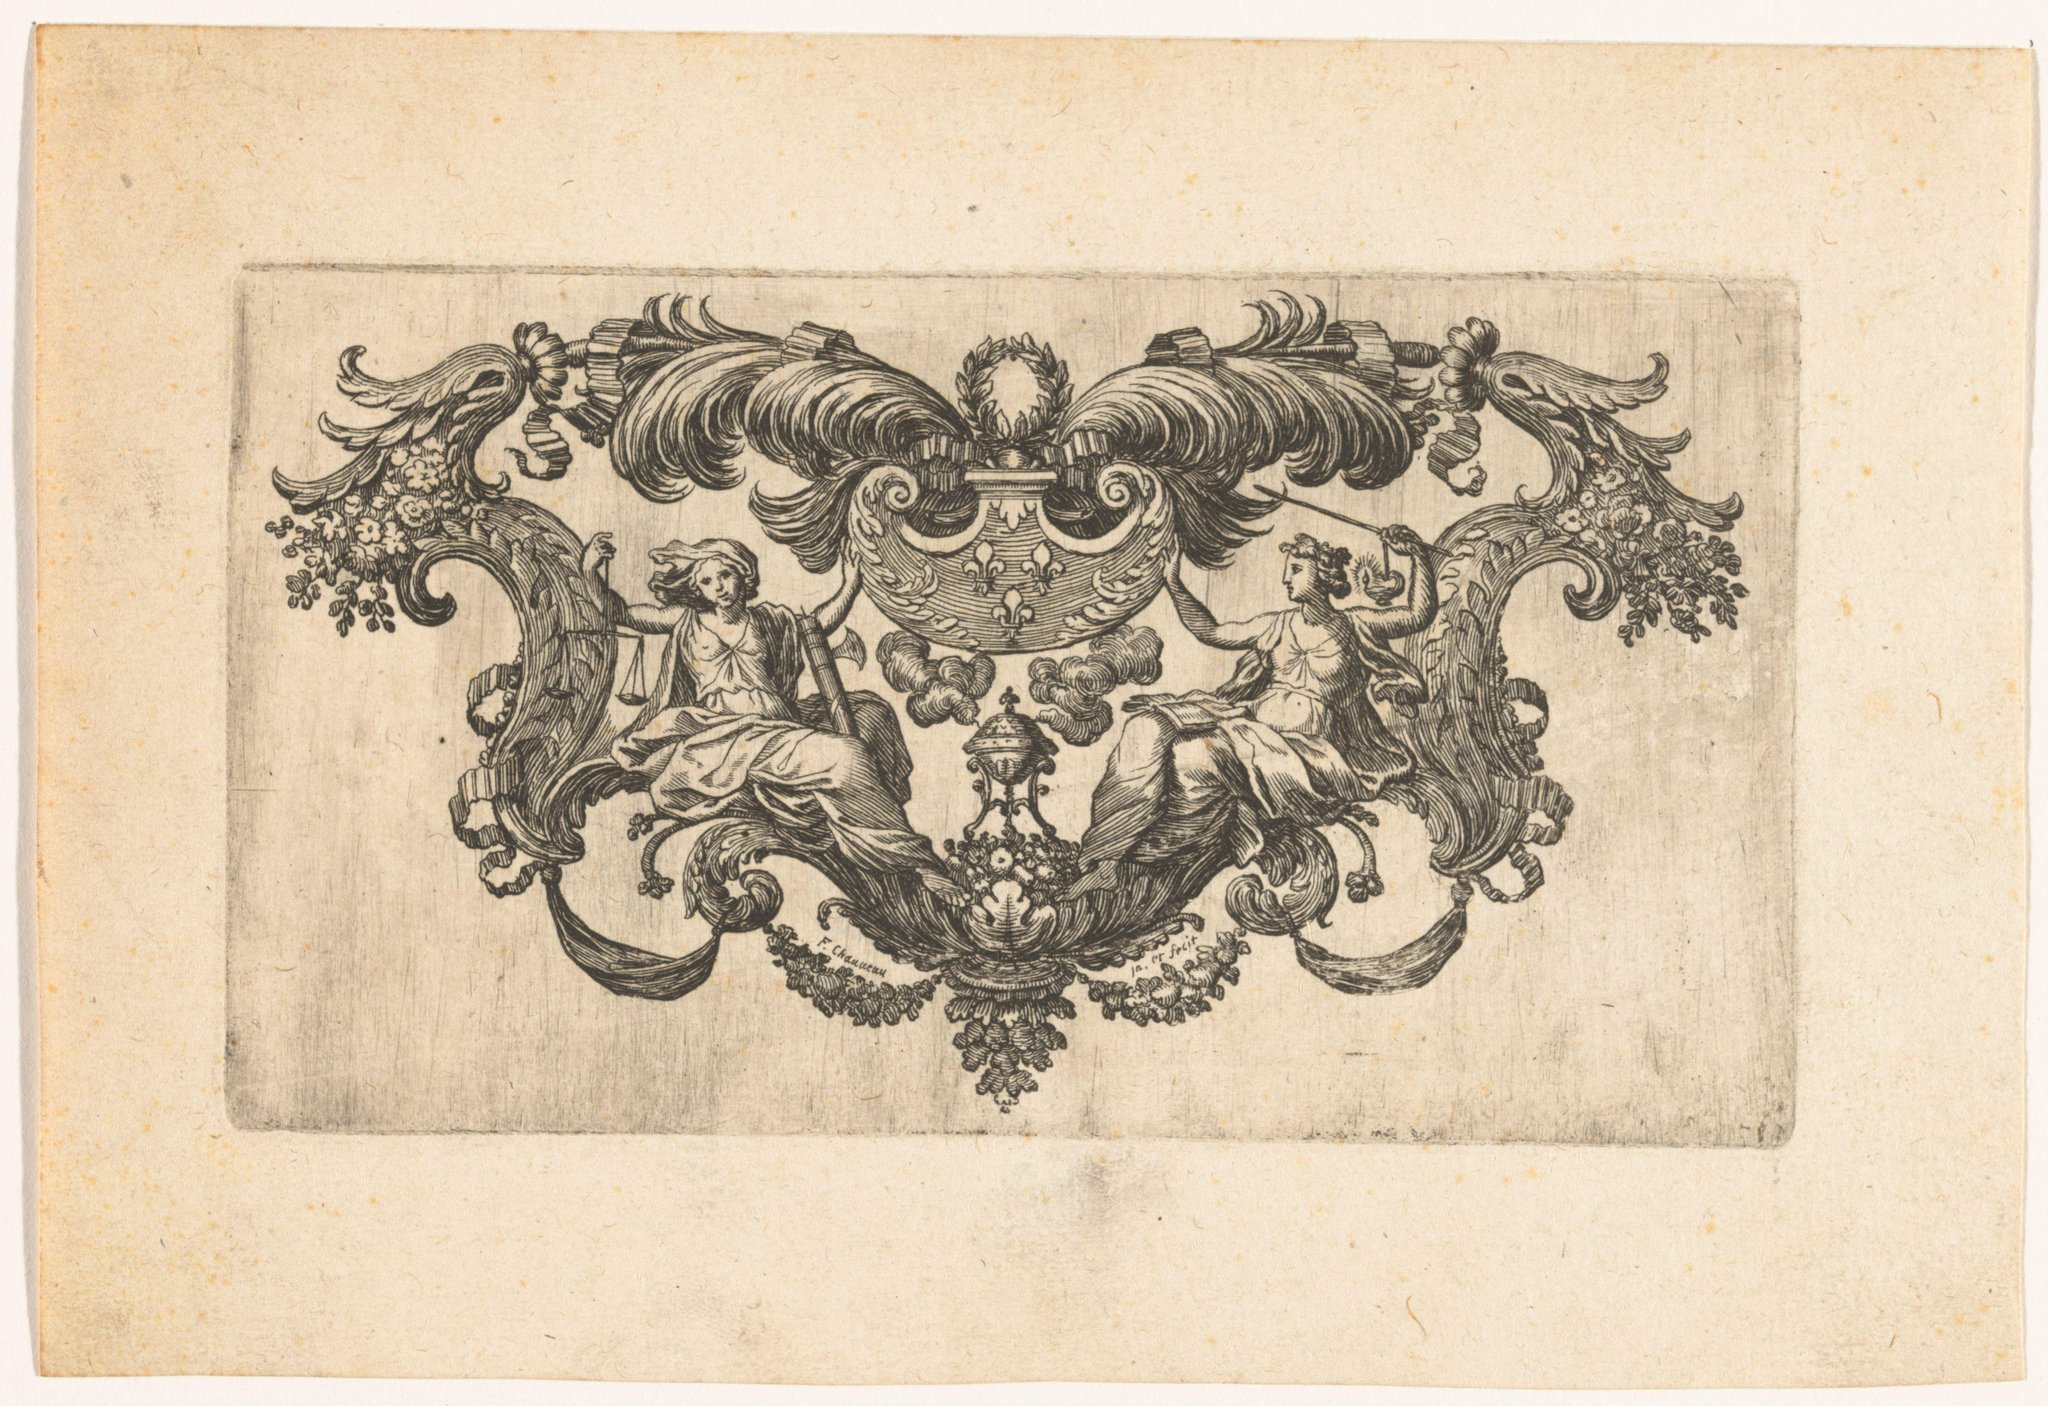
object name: print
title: Vignet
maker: françois chauveau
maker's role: draughtsman, painter, print maker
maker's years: 1613-1676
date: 1623-1676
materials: paper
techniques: engraving, etching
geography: paris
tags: fleur-de-lis ~ ornament, vessels and utensils used in the church, trees: laurel, representations ~ goddesses, demi-goddesses, heroines, etc. (non-christian religions), vignette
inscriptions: collector's mark: Lugt 2228, signature: ‘F. Chauueau In. et fecit’, collector's mark: Lugt 2760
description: Vignet bestaande uit ranken en bloemen met twee godinnen, een rookvat, de Franse lelie en een lauwerkrans.